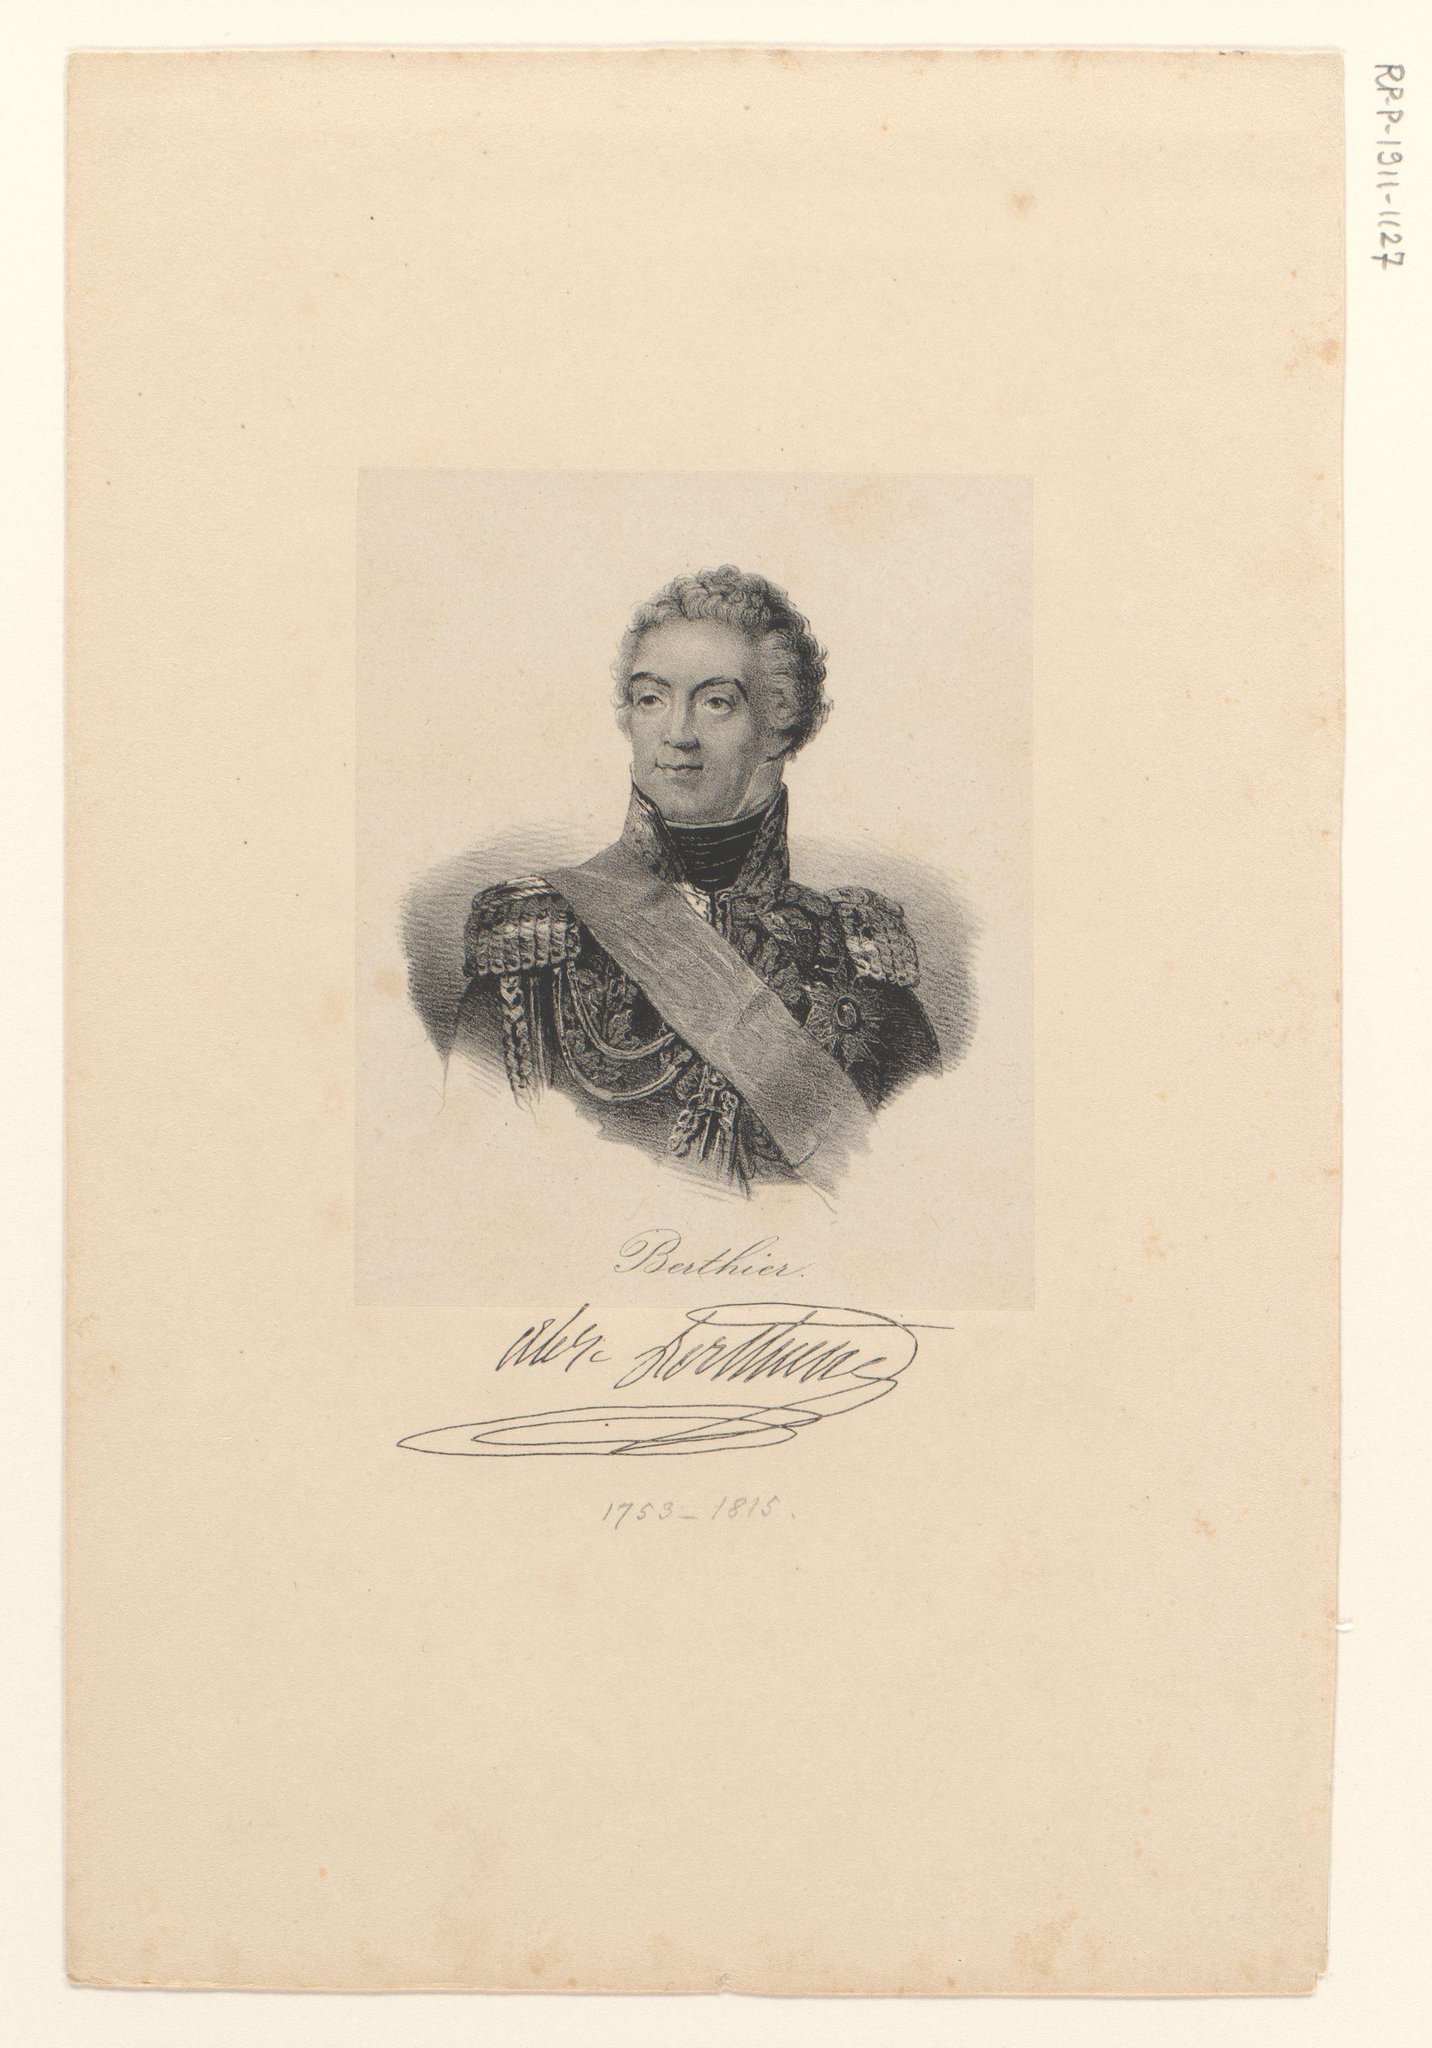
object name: print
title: Portret van Louis-Alexandre Berthier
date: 1818-1842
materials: paper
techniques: lithograph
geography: paris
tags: historical persons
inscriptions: collector's mark: Lugt 2228a